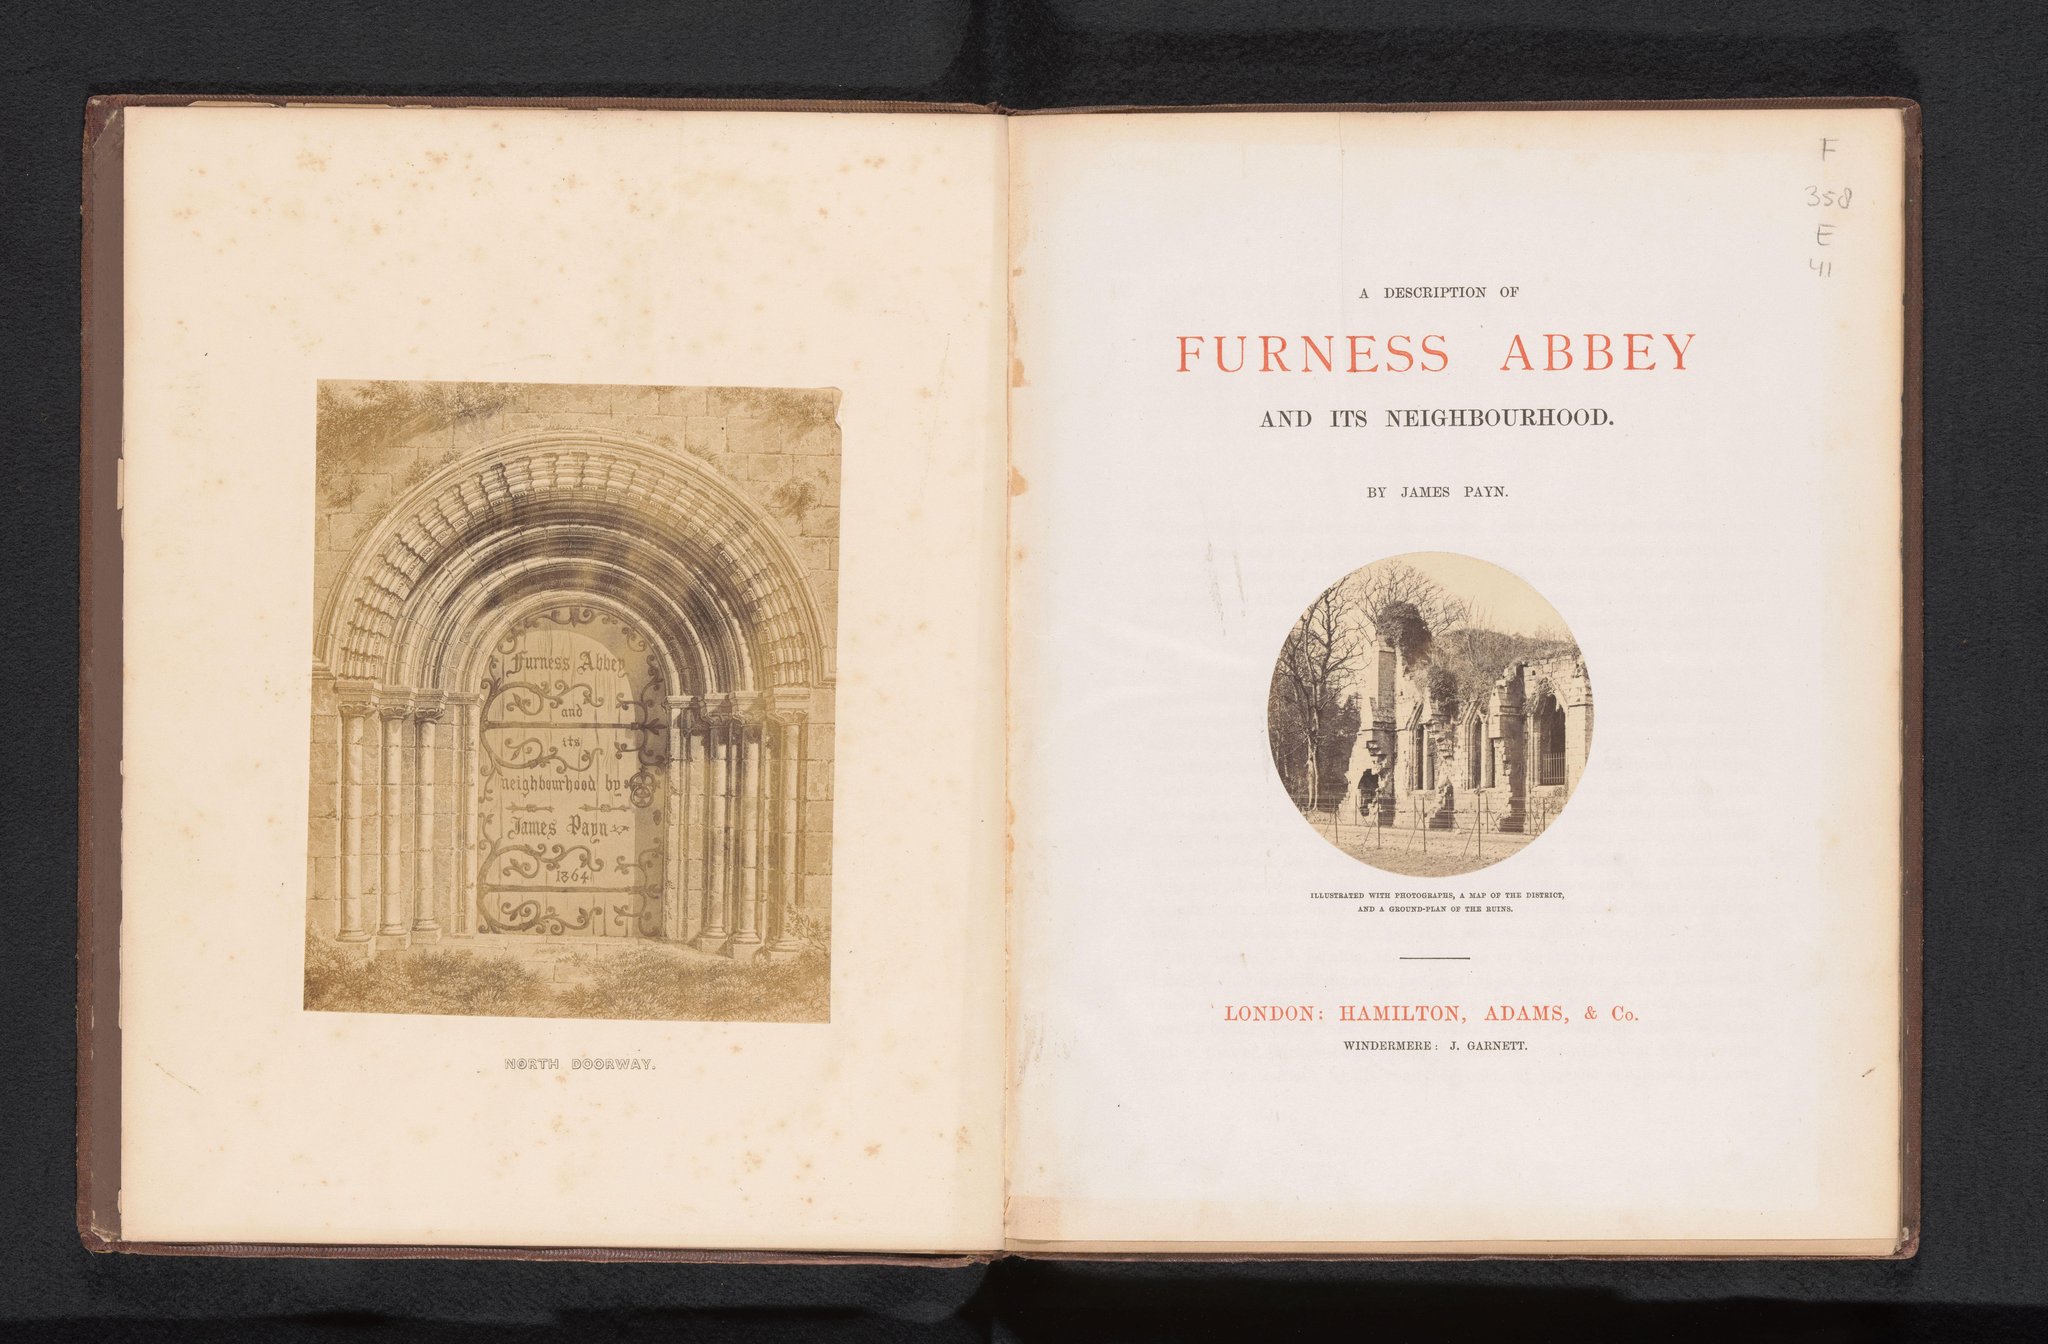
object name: book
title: A description of Furness abbey and its neighboorhood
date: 1864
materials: cardboard, linen, paper, photographic support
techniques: albumen print, printing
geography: windermere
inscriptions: inscription: ‘For dear Auntie, as a small souvenir of the Lakes from L.S. & H.S. August 17th 1865’, inscription: ‘Epsom College Library Class No. 727 - 7 Accession No. 8303’